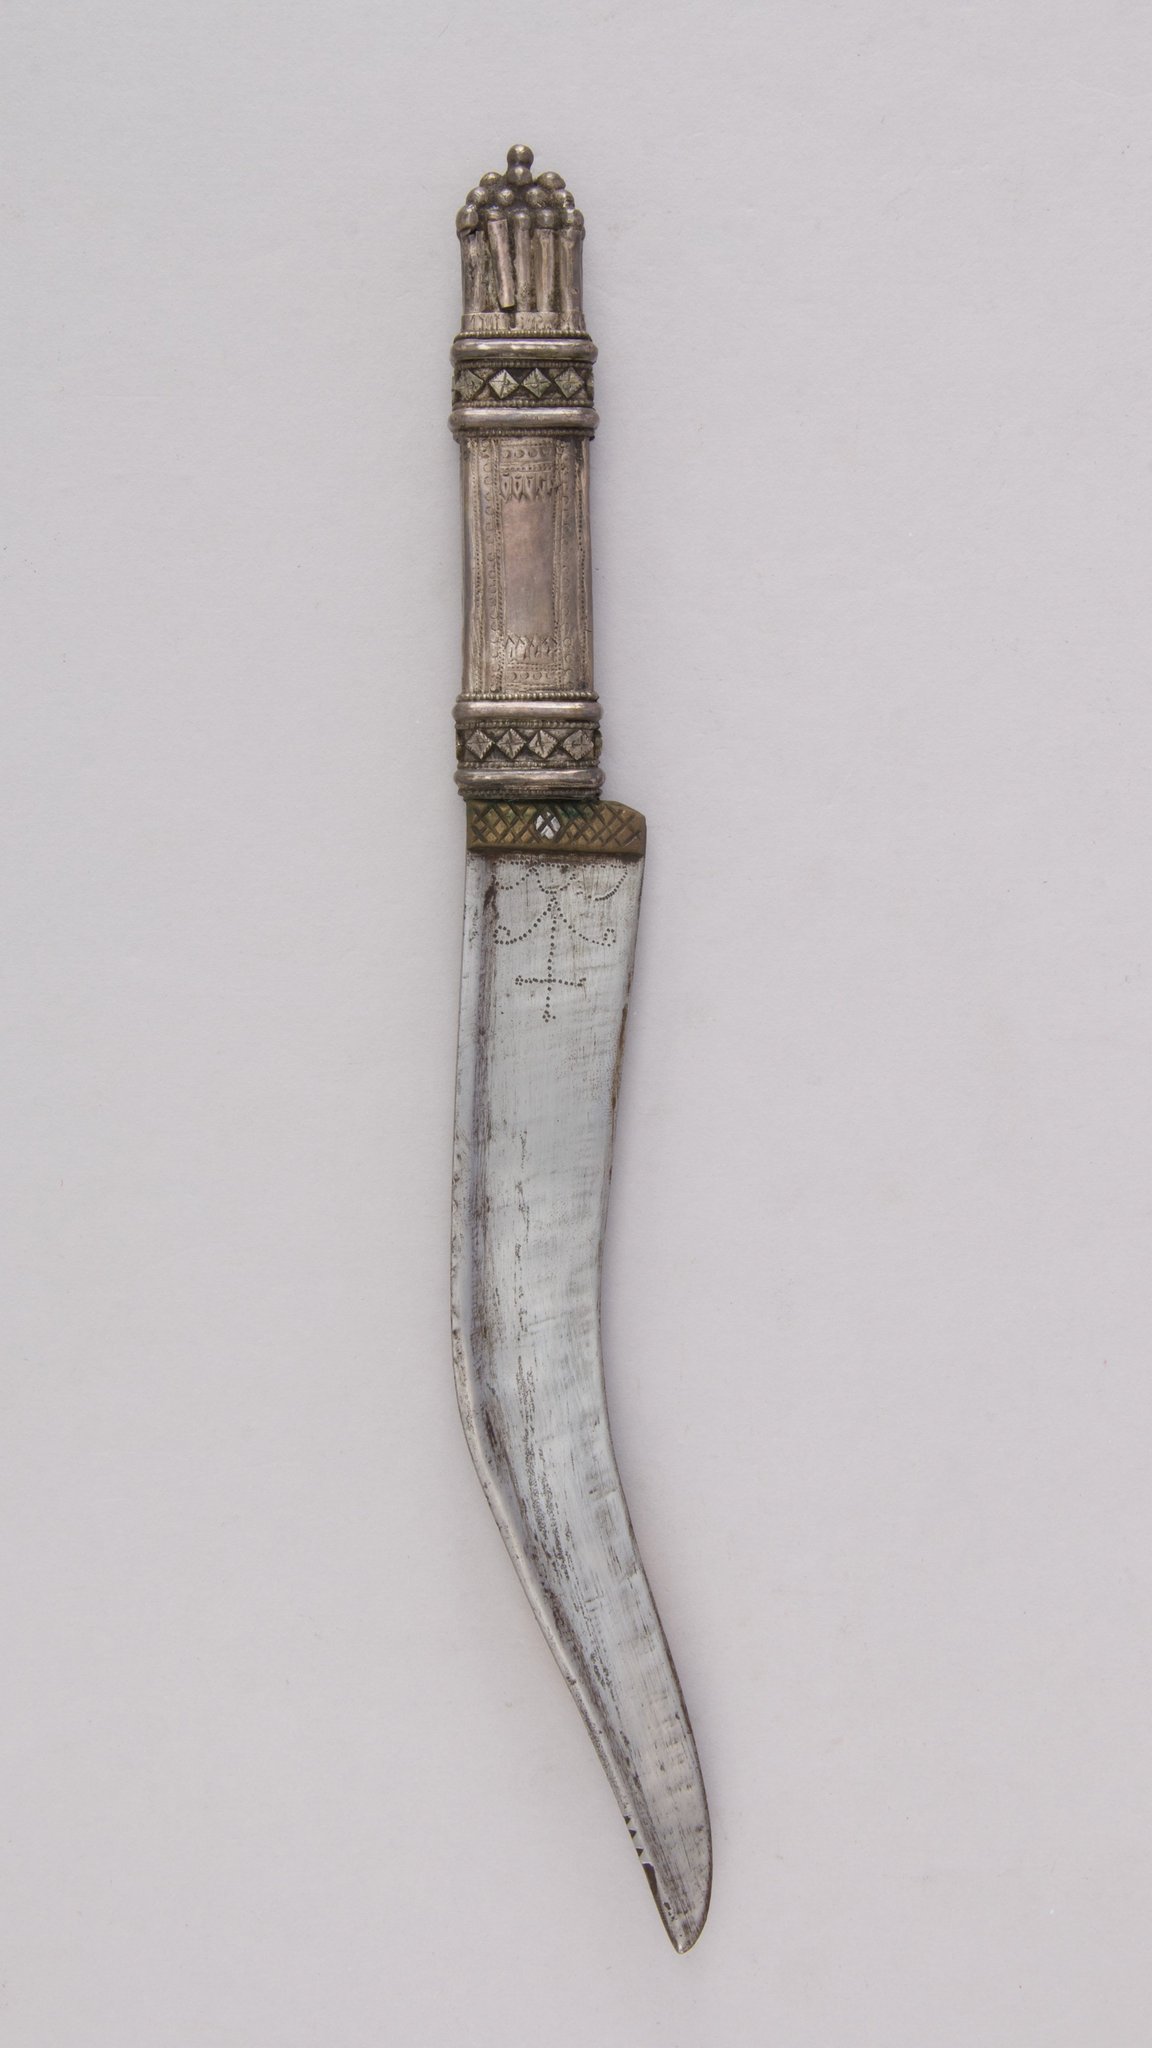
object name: knife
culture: indian or nepalese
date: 1701-1900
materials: brass, silver, steel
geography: india